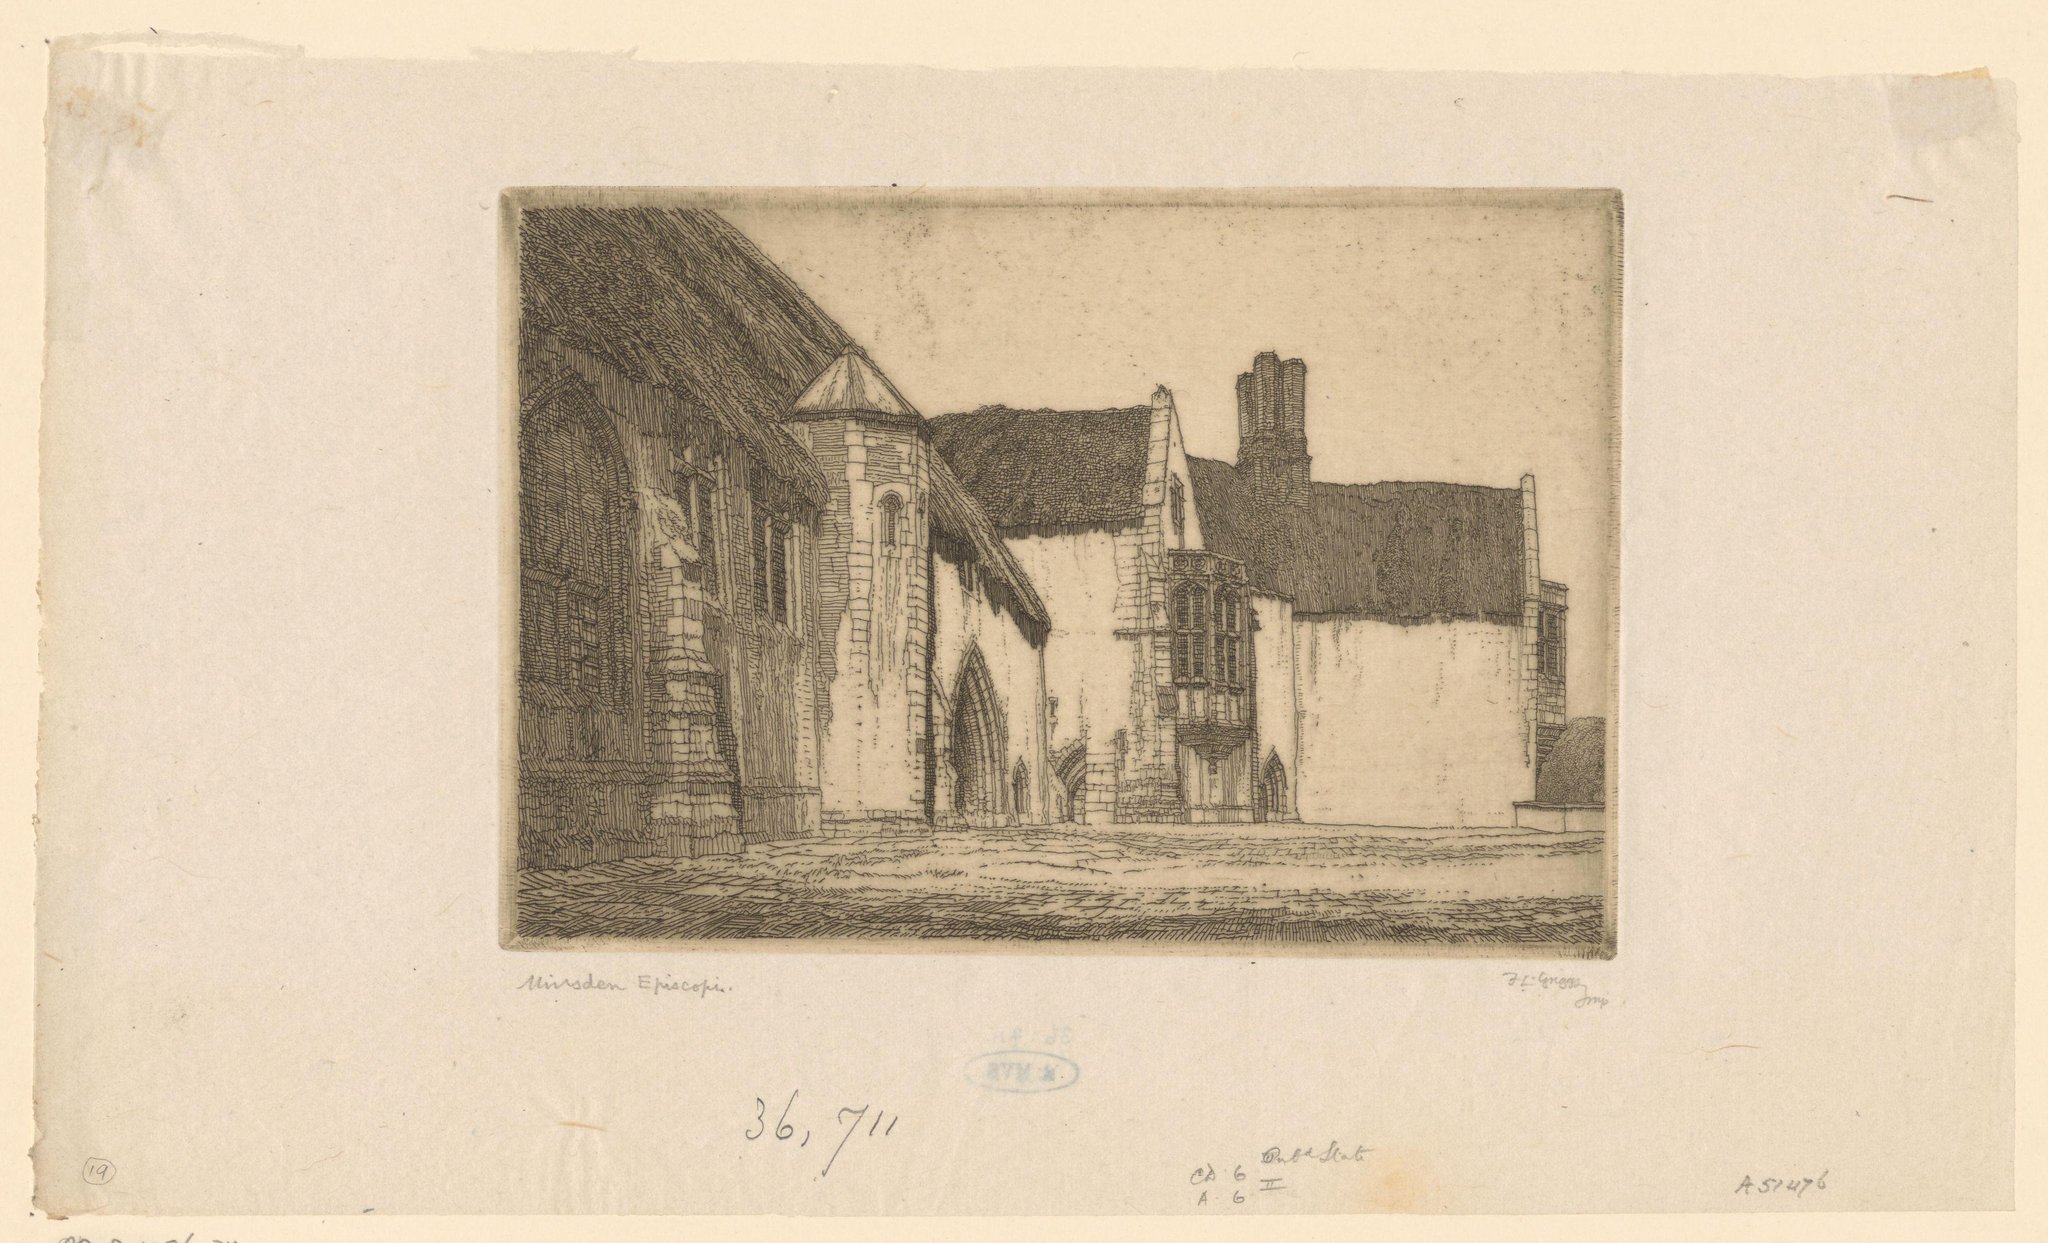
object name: print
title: Vervallen middeleeuws gebouw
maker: frederick landseer maur griggs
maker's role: print maker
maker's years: 1876-1938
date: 1913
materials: paper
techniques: etching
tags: exterior ~ ideal or visionary architectural design or model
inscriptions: signature: ‘F.L. Griggs Imp.’, collector's mark: Lugt 2228, title: ‘Minsden Episcopi’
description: Dodgson en Alexander noemen twee staten van 'Minsden Episcopi', maar deze plaat is later hergebruikt voor de prent 'Palace Farm'. Hier zijn nog drie staten van.